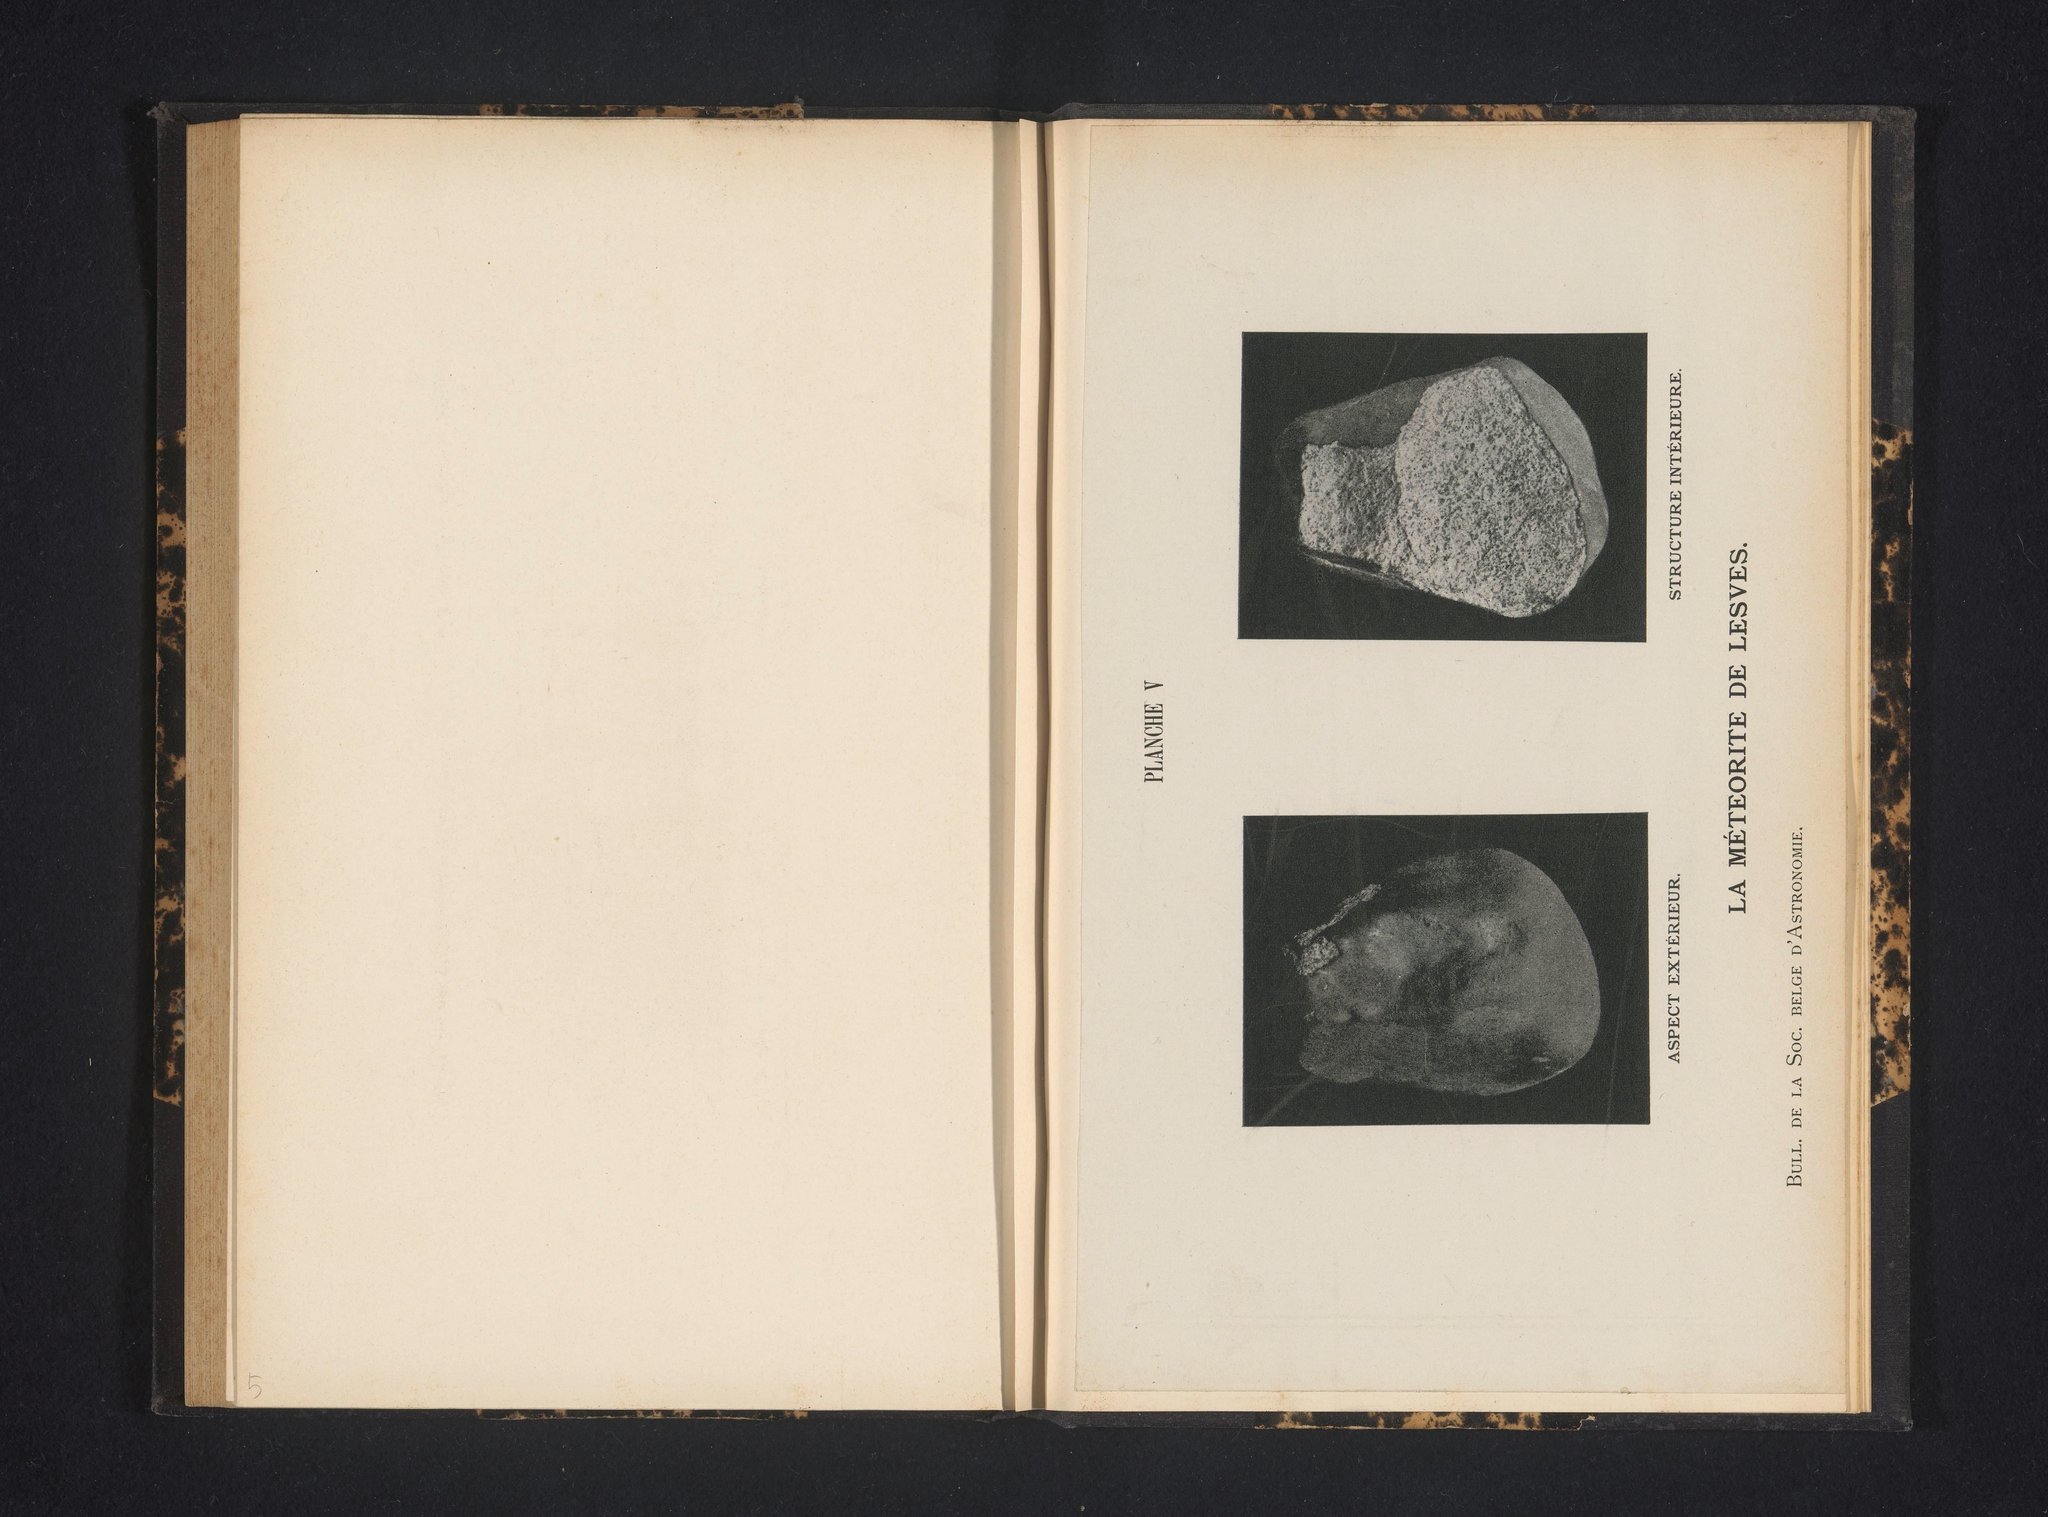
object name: page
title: La météorite de lesves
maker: Anonymous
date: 1890-1896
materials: paper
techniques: autotype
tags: 24e3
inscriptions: inscription: ‘Aspect Extérieur/ Structure Intérieure’